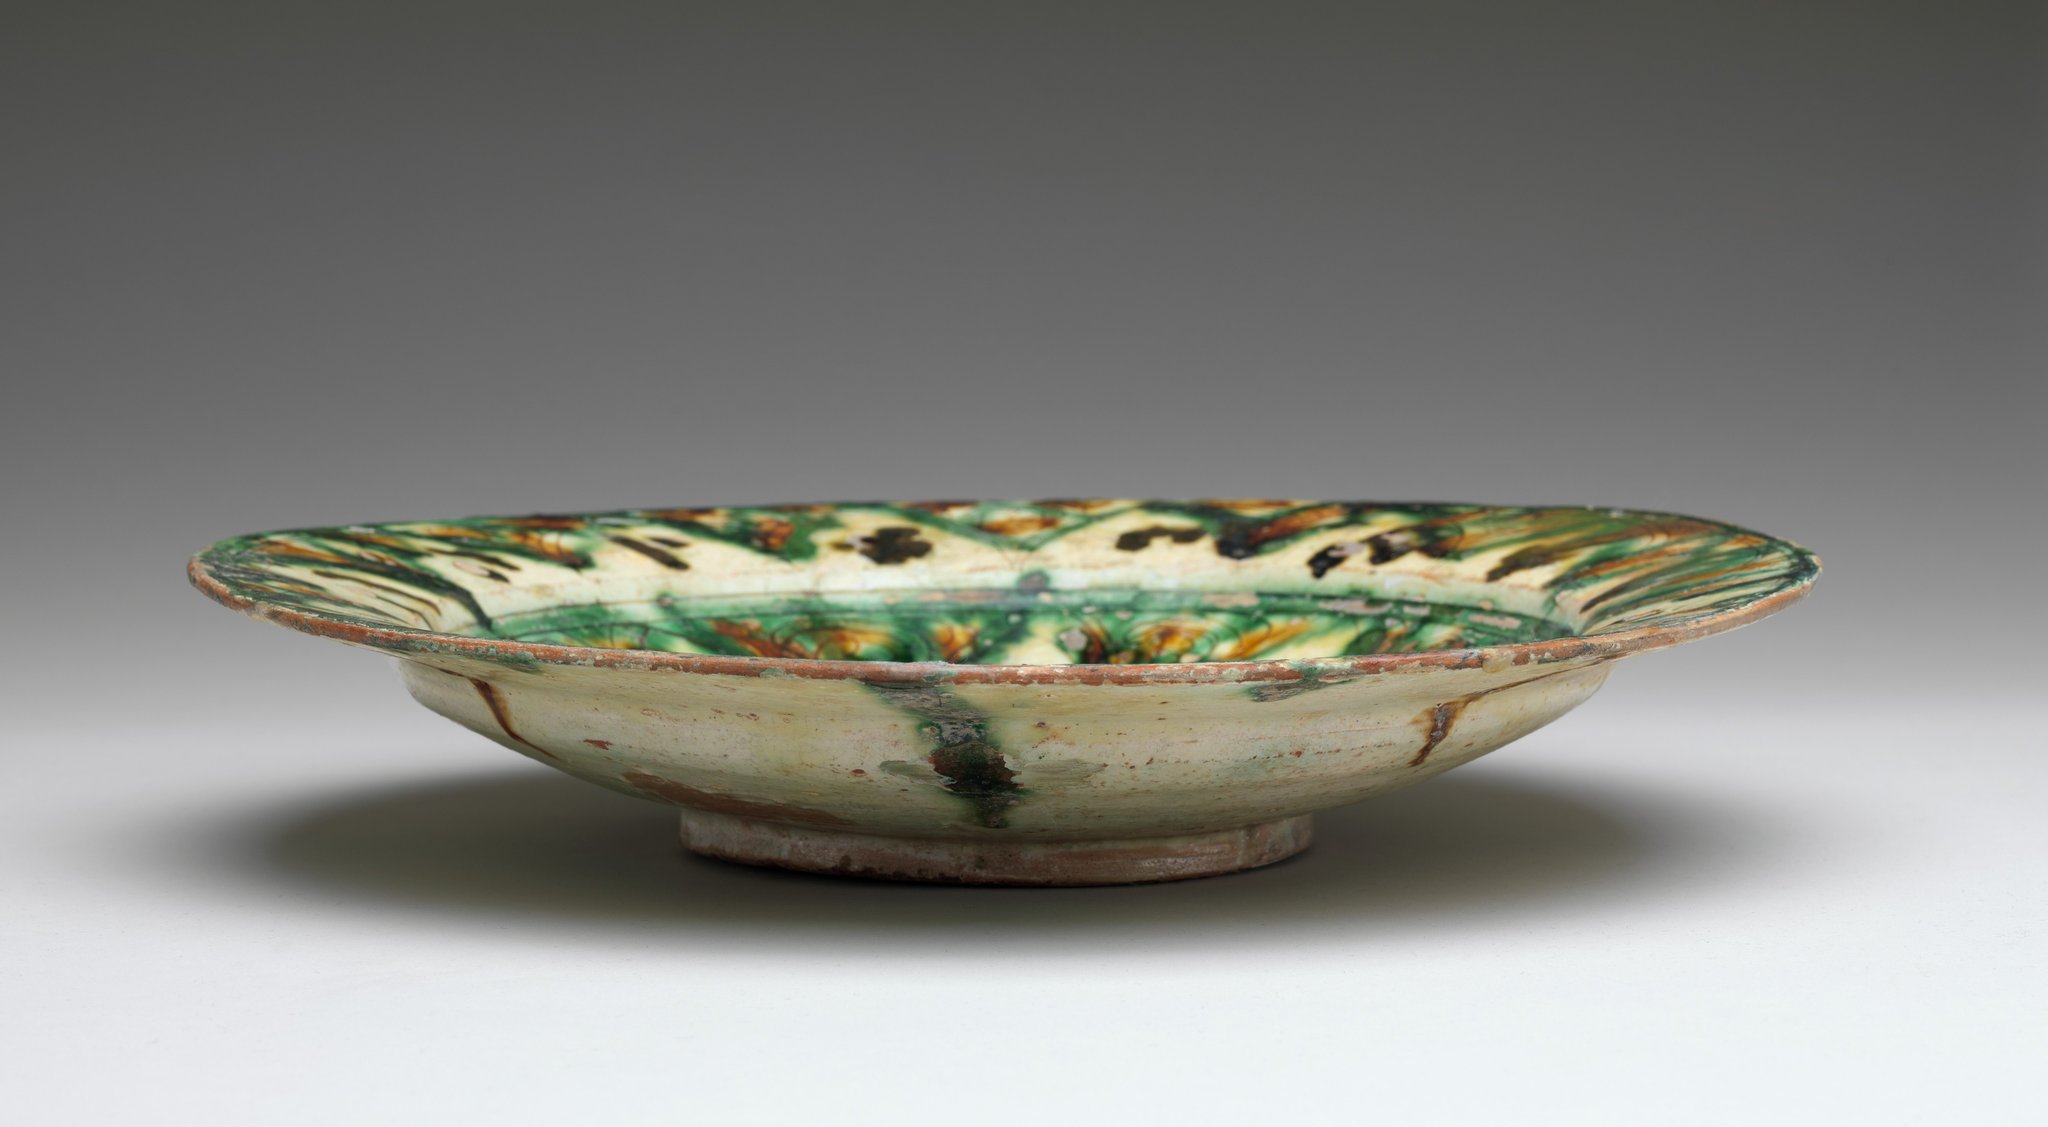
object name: dish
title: Imitation Splashware Dish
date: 901-1000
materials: earthenware, glaze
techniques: incising, polychrome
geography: iran